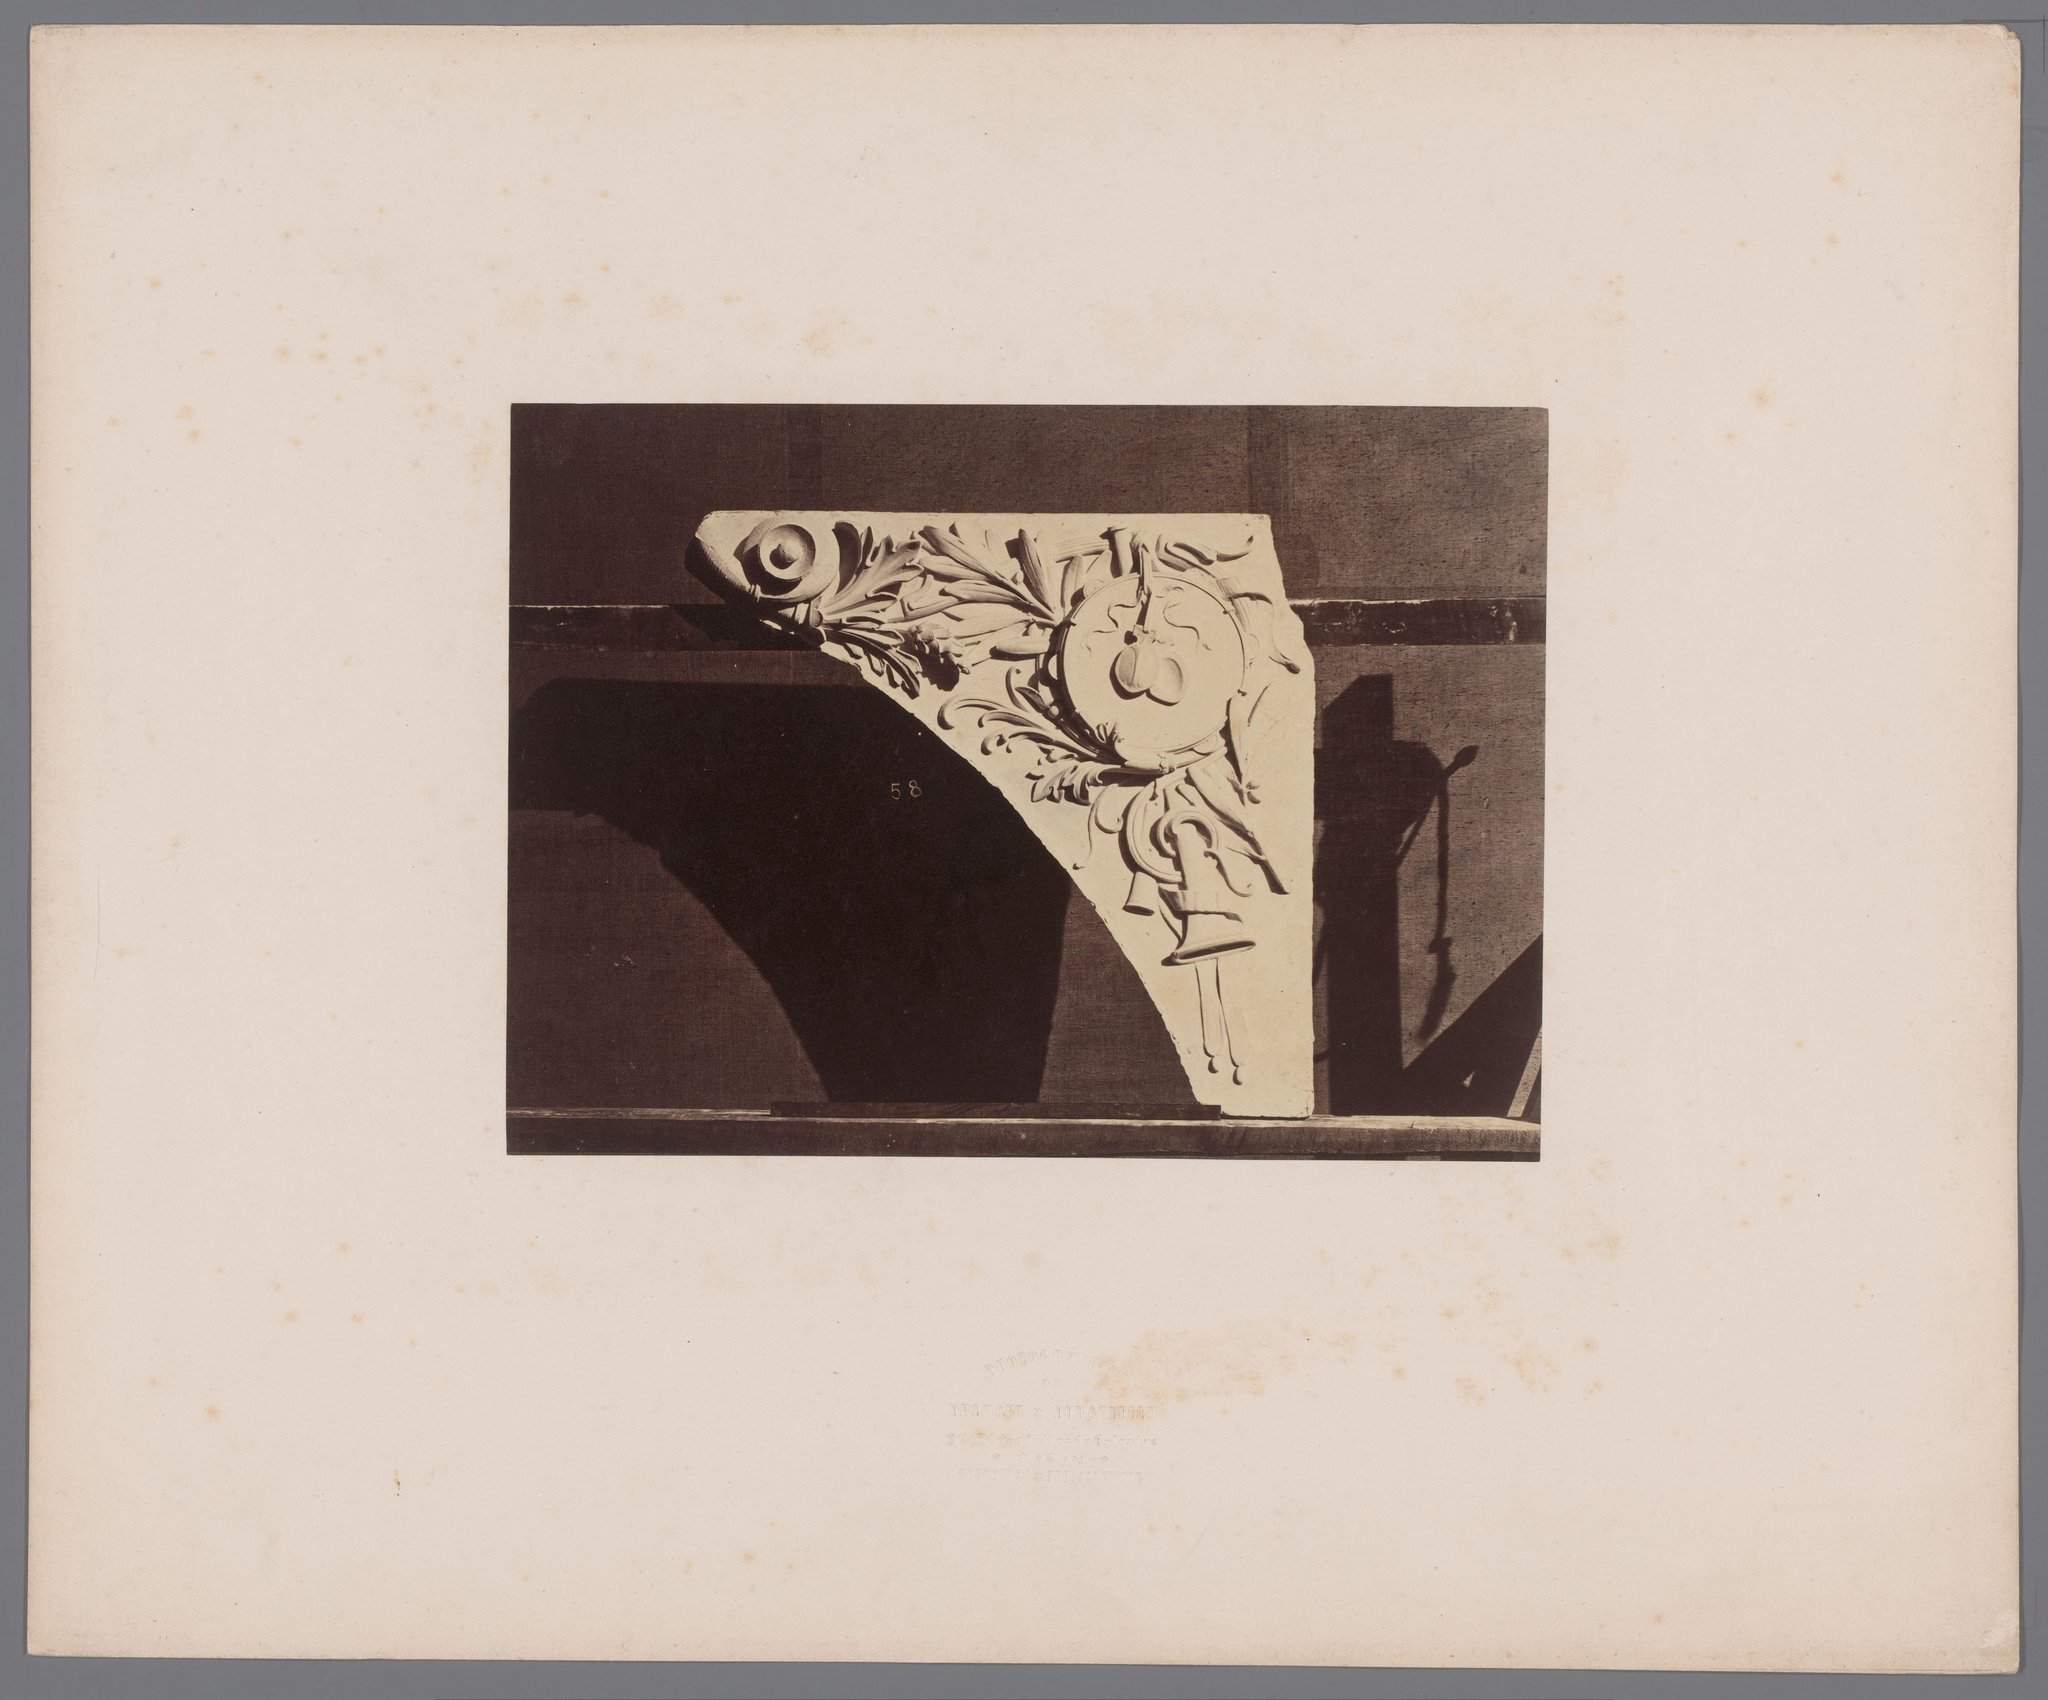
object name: photograph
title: Bouwfragment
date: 1870-1890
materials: cardboard, photographic support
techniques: albumen print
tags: architectural detail